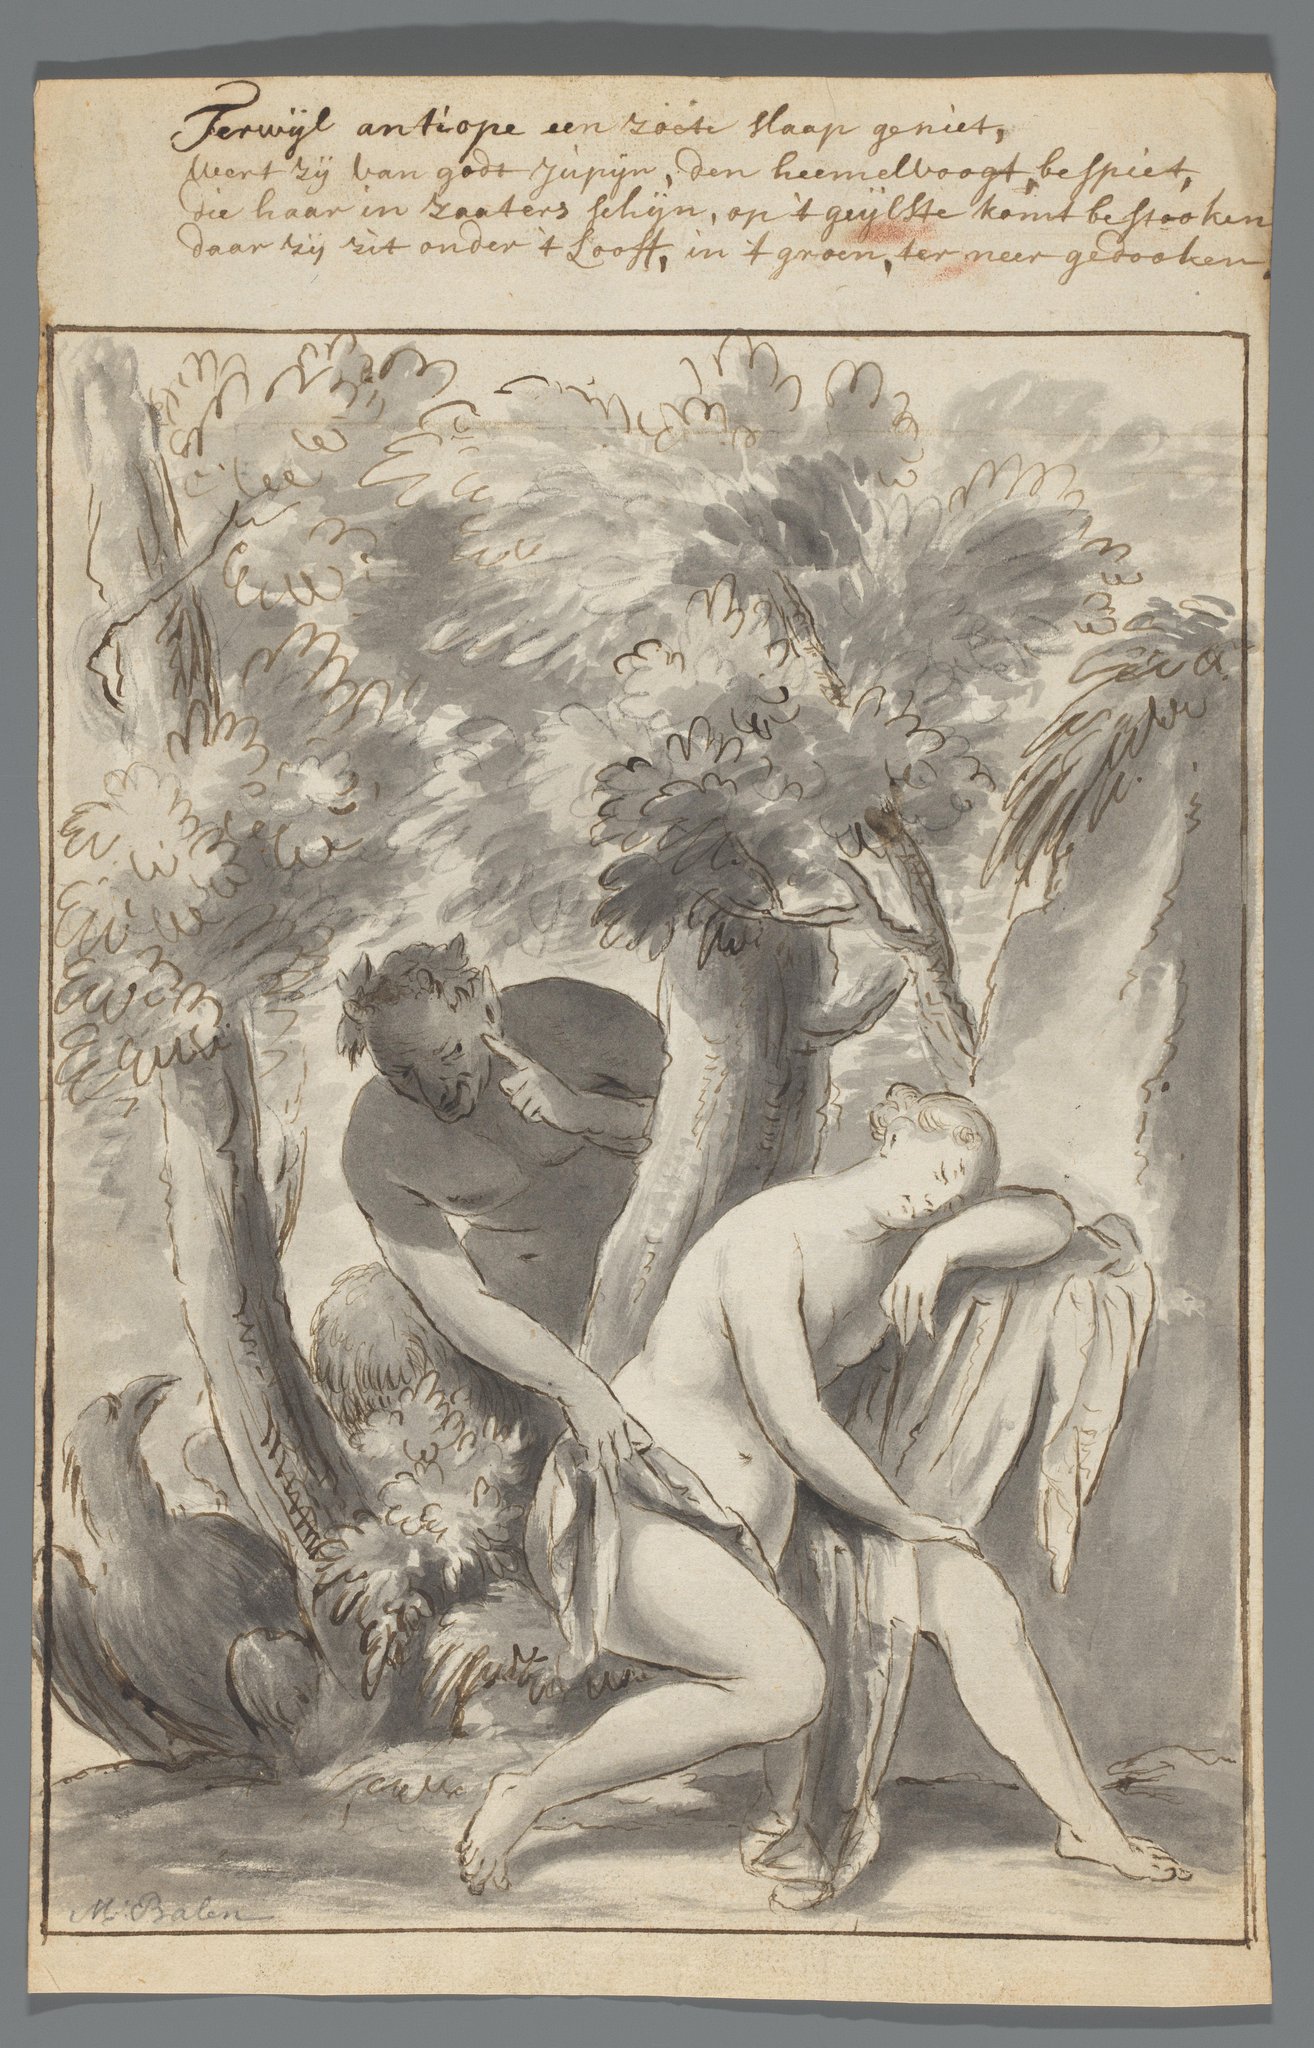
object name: drawing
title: Jupiter en Antiope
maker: matthijs balen (1684-1766)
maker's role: draughtsman, painter, print maker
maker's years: 1684-1766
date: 1694-1766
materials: paper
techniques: brush, pen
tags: jupiter, disguised as a satyr, approaches the sleeping antiope; the eagle may be standing nearby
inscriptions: inscription: ‘Terwijl Antiope een zoete slaap geniet,/ wert zij van godt Jupijn, den heemelvoogt, bespiet,/ die haar in zaaters schijn, op `t geijlste komt bestooken/ daar zij zit onder 't looft, in 't groen, ter neer gedooken.’